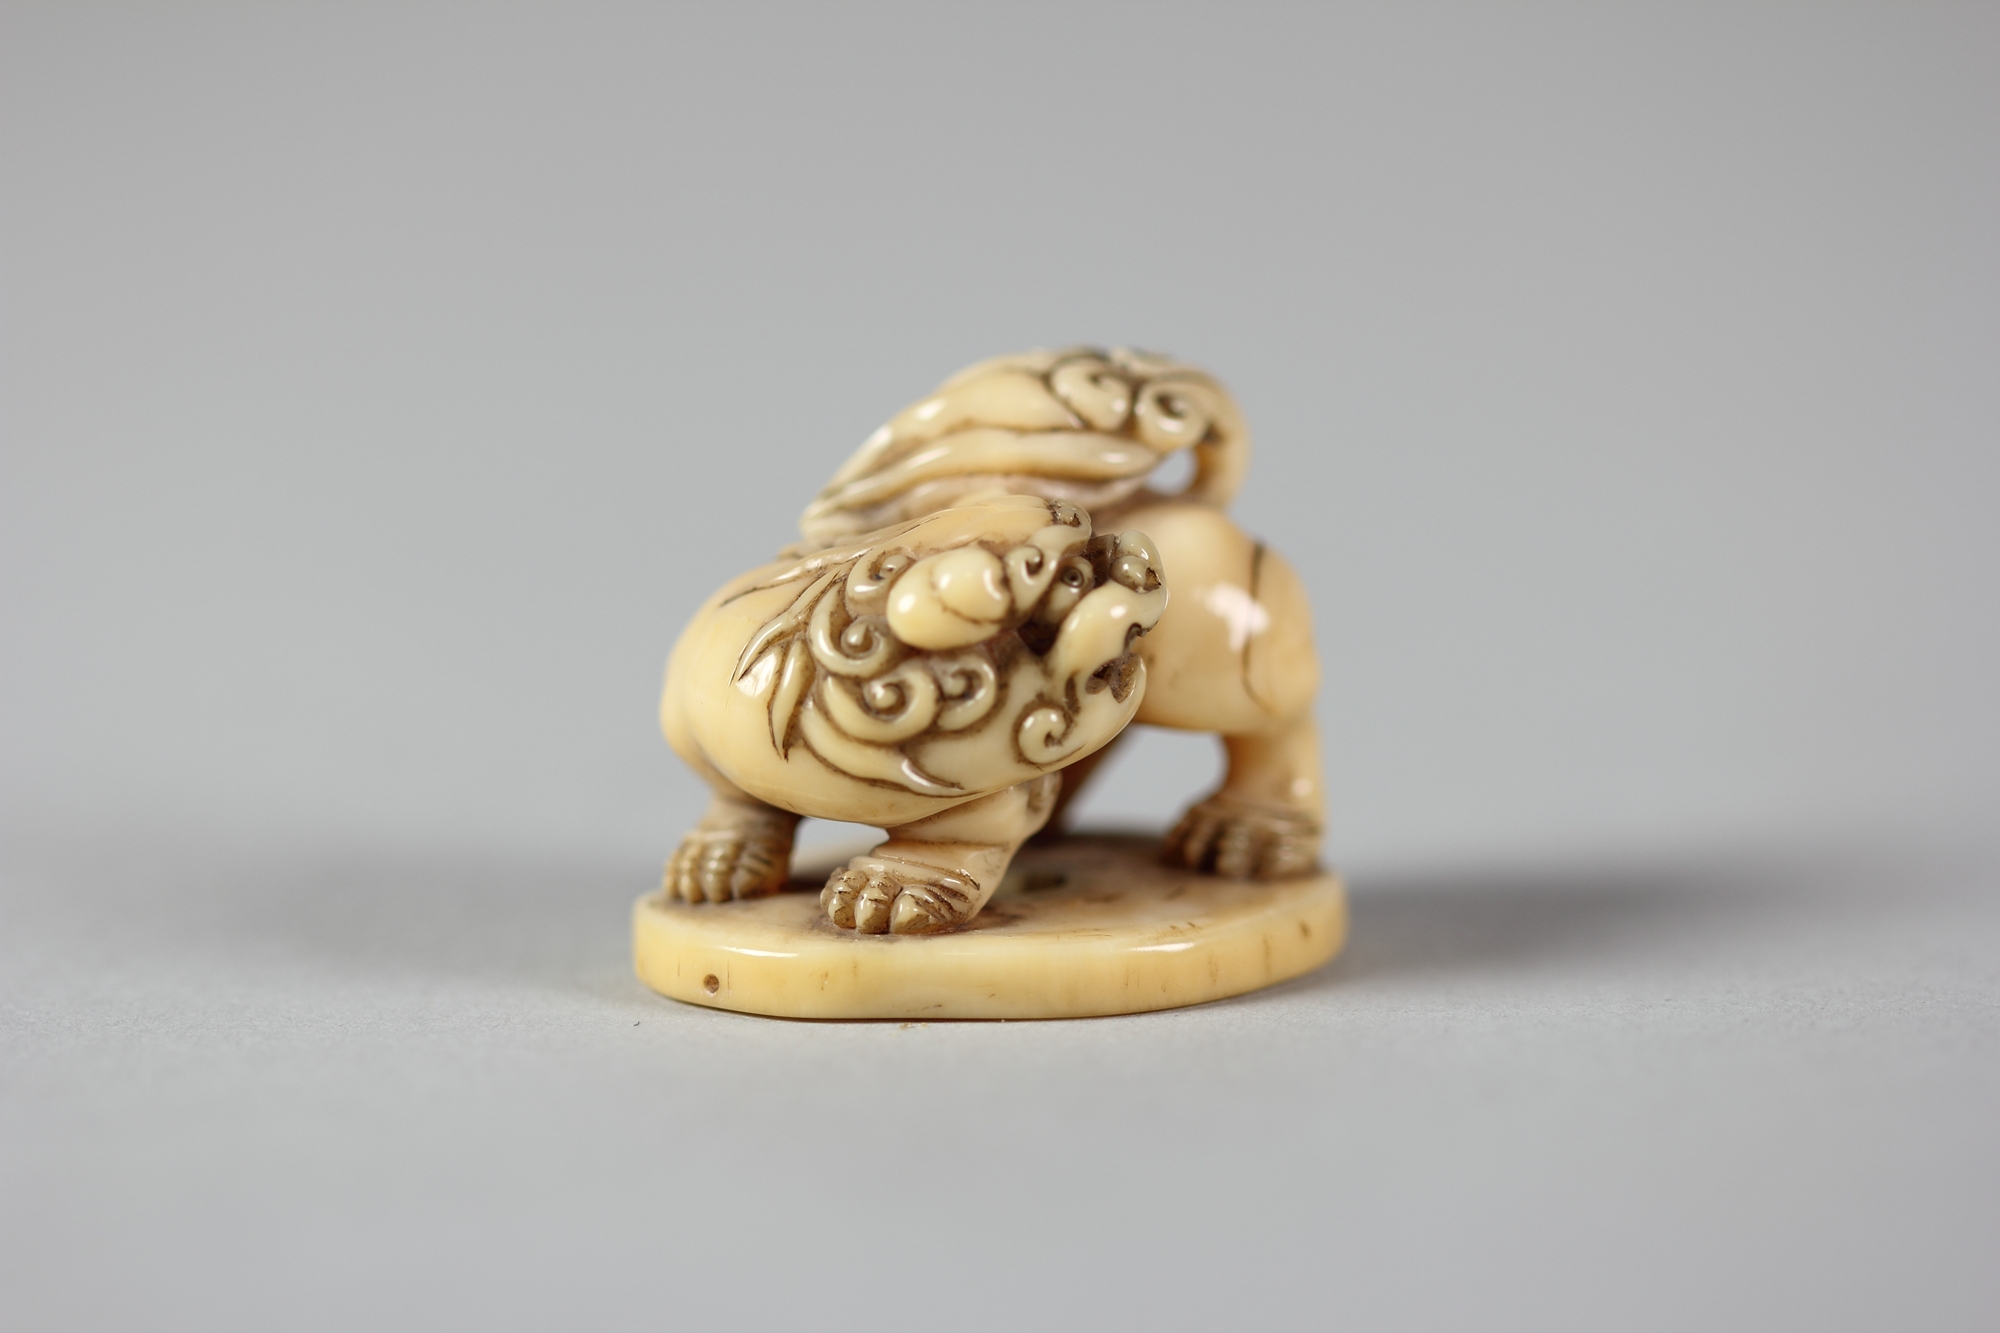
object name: netsuke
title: Netsuke of Qilin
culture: japanese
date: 1801-1900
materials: ivory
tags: mythical creatures